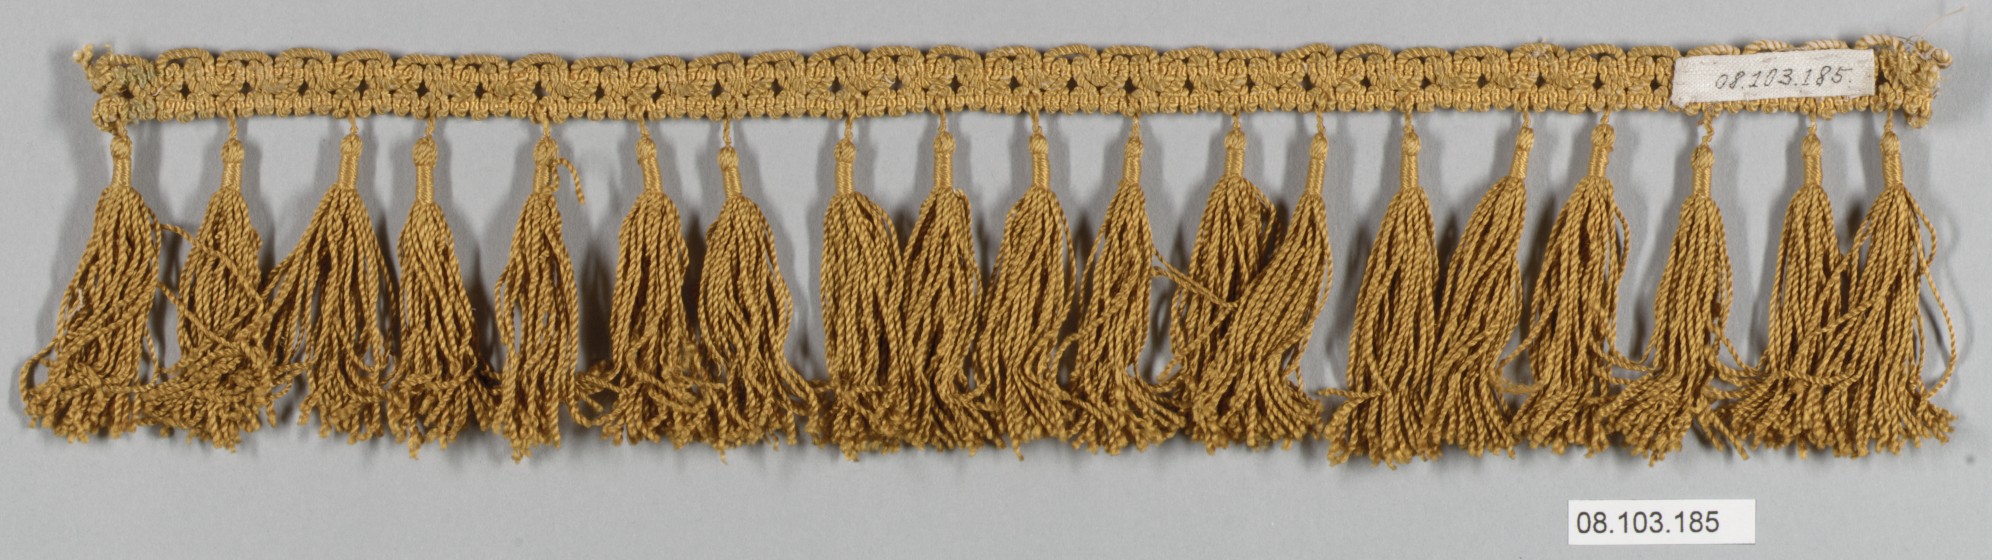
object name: fringe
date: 1801-1900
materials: silk